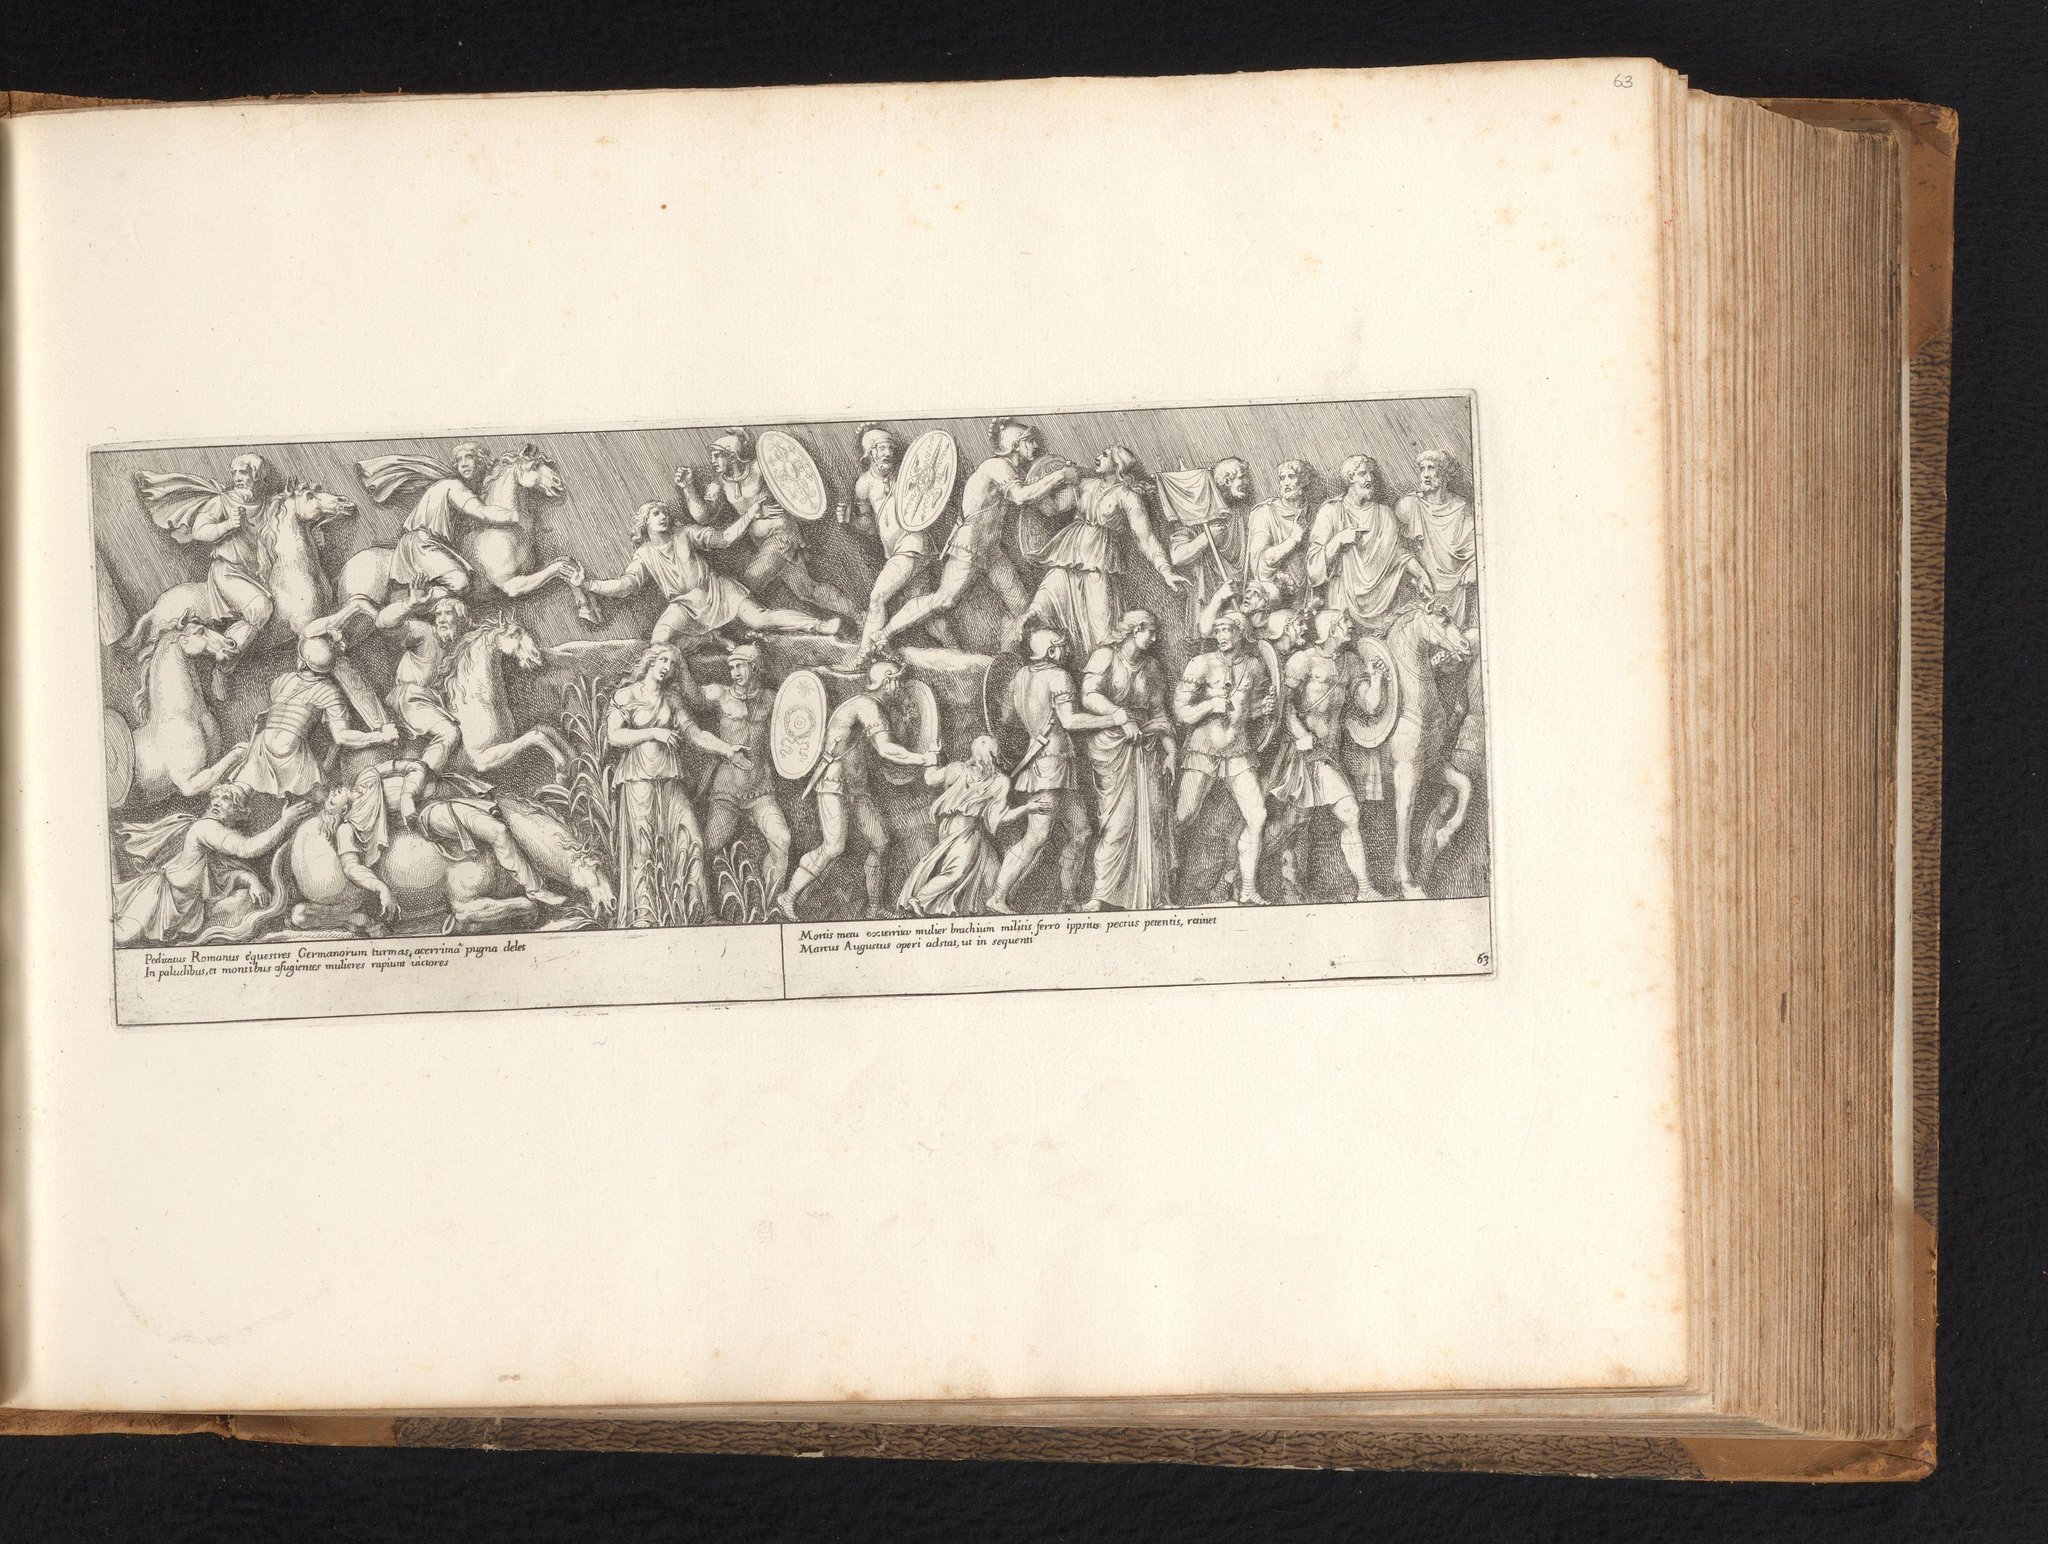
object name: album leaf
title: Zuil van Marcus Aurelius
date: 1672-1675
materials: paper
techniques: etching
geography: rome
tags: triumphal column with helical friezes, piece of sculpture, reproduction of a piece of sculpture, the soldier; the soldier's life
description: Detail van het spiraalvormige gebeeldhouwde fries op de Zuil van Marcus Aurelius te Rome. Het fries toont de oorlog tussen het Romeinse leger van keizer Marcus Aurelius en de Germaanse stammen der Marcomannen en Quaden en de oorlog tegen de Sarmaten die vanuit het huidige Iran Hongarije waren binnengevallen. Tekst in de ondermarge. Prent maakt deel uit van een album.